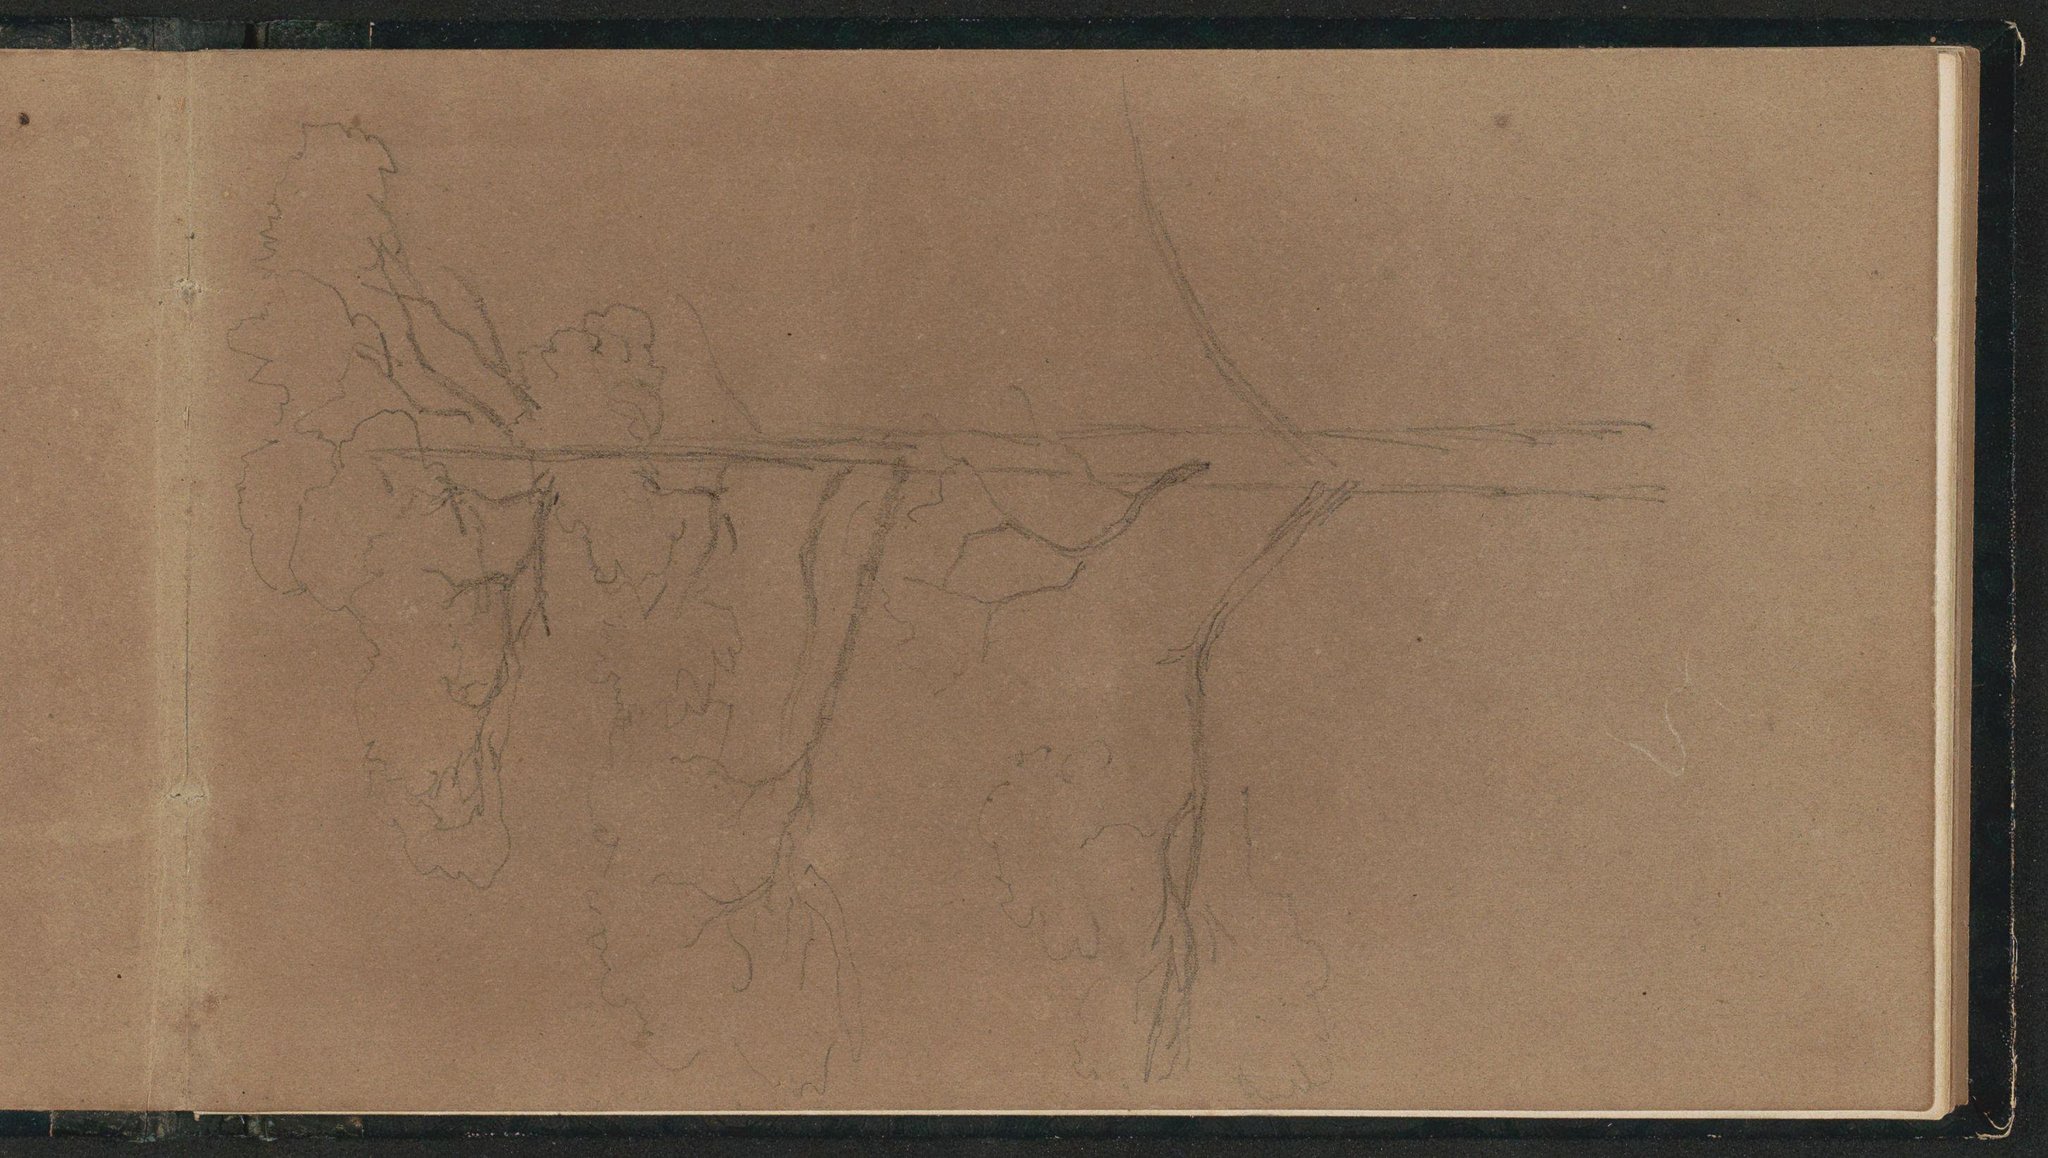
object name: sketchbook leaf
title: Boom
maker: charles rochussen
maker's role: draughtsman, painter, print maker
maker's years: 1814-1894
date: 1840-1860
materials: paper, pencil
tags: trees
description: Recto van het voorste vrije schutblad uit een schetsboek met 38 bladen.